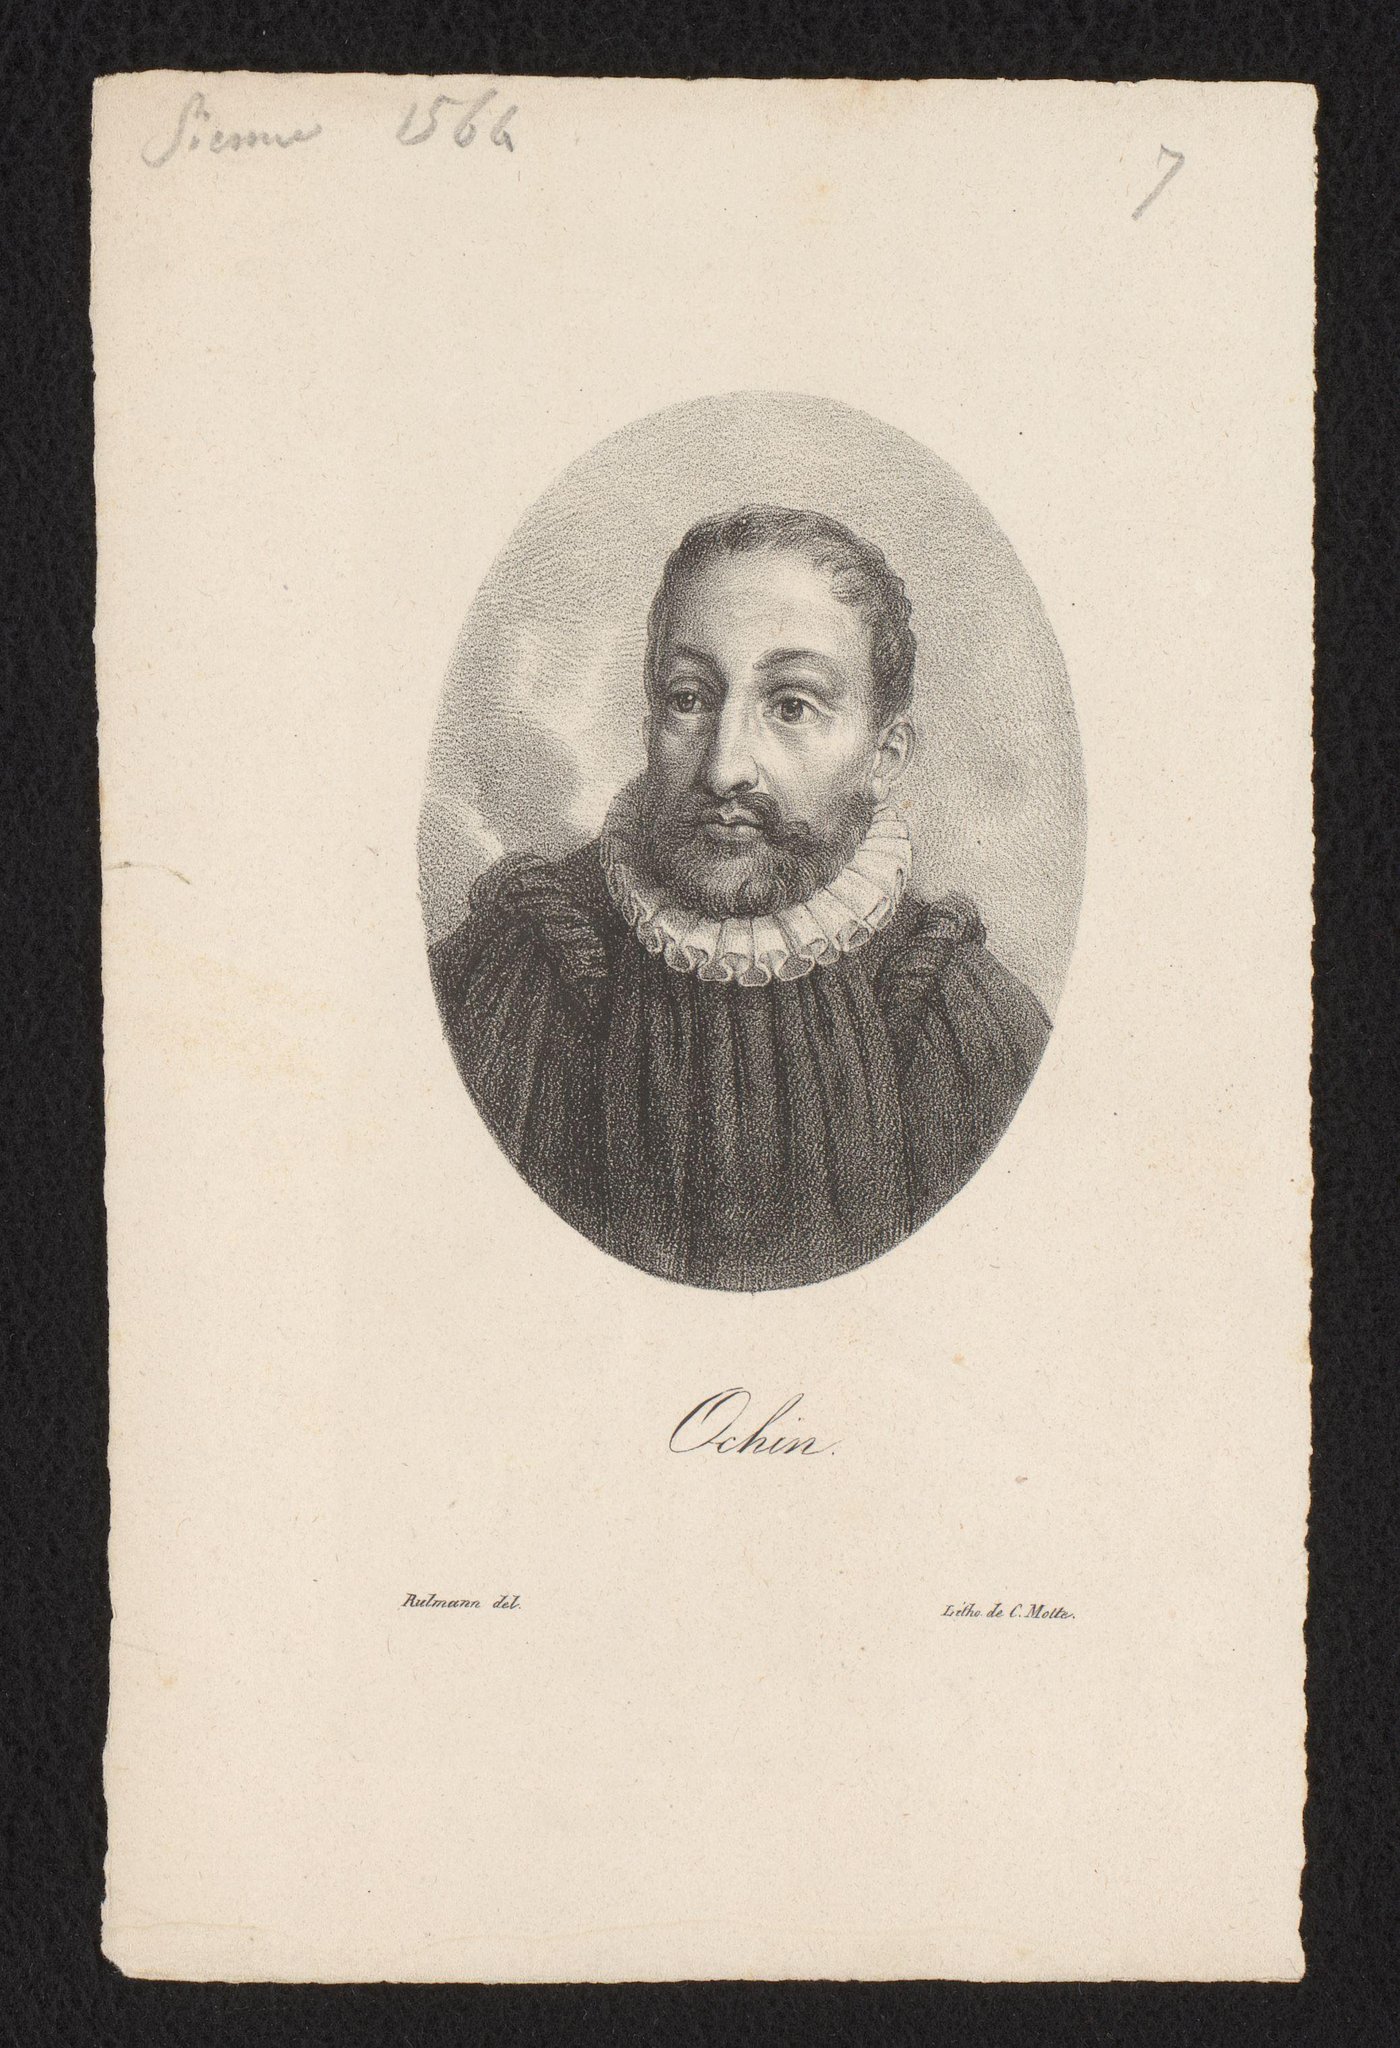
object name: print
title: Ochin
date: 1817-1837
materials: paper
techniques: lithograph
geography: paris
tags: historical persons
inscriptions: collector's mark: Lugt 2228